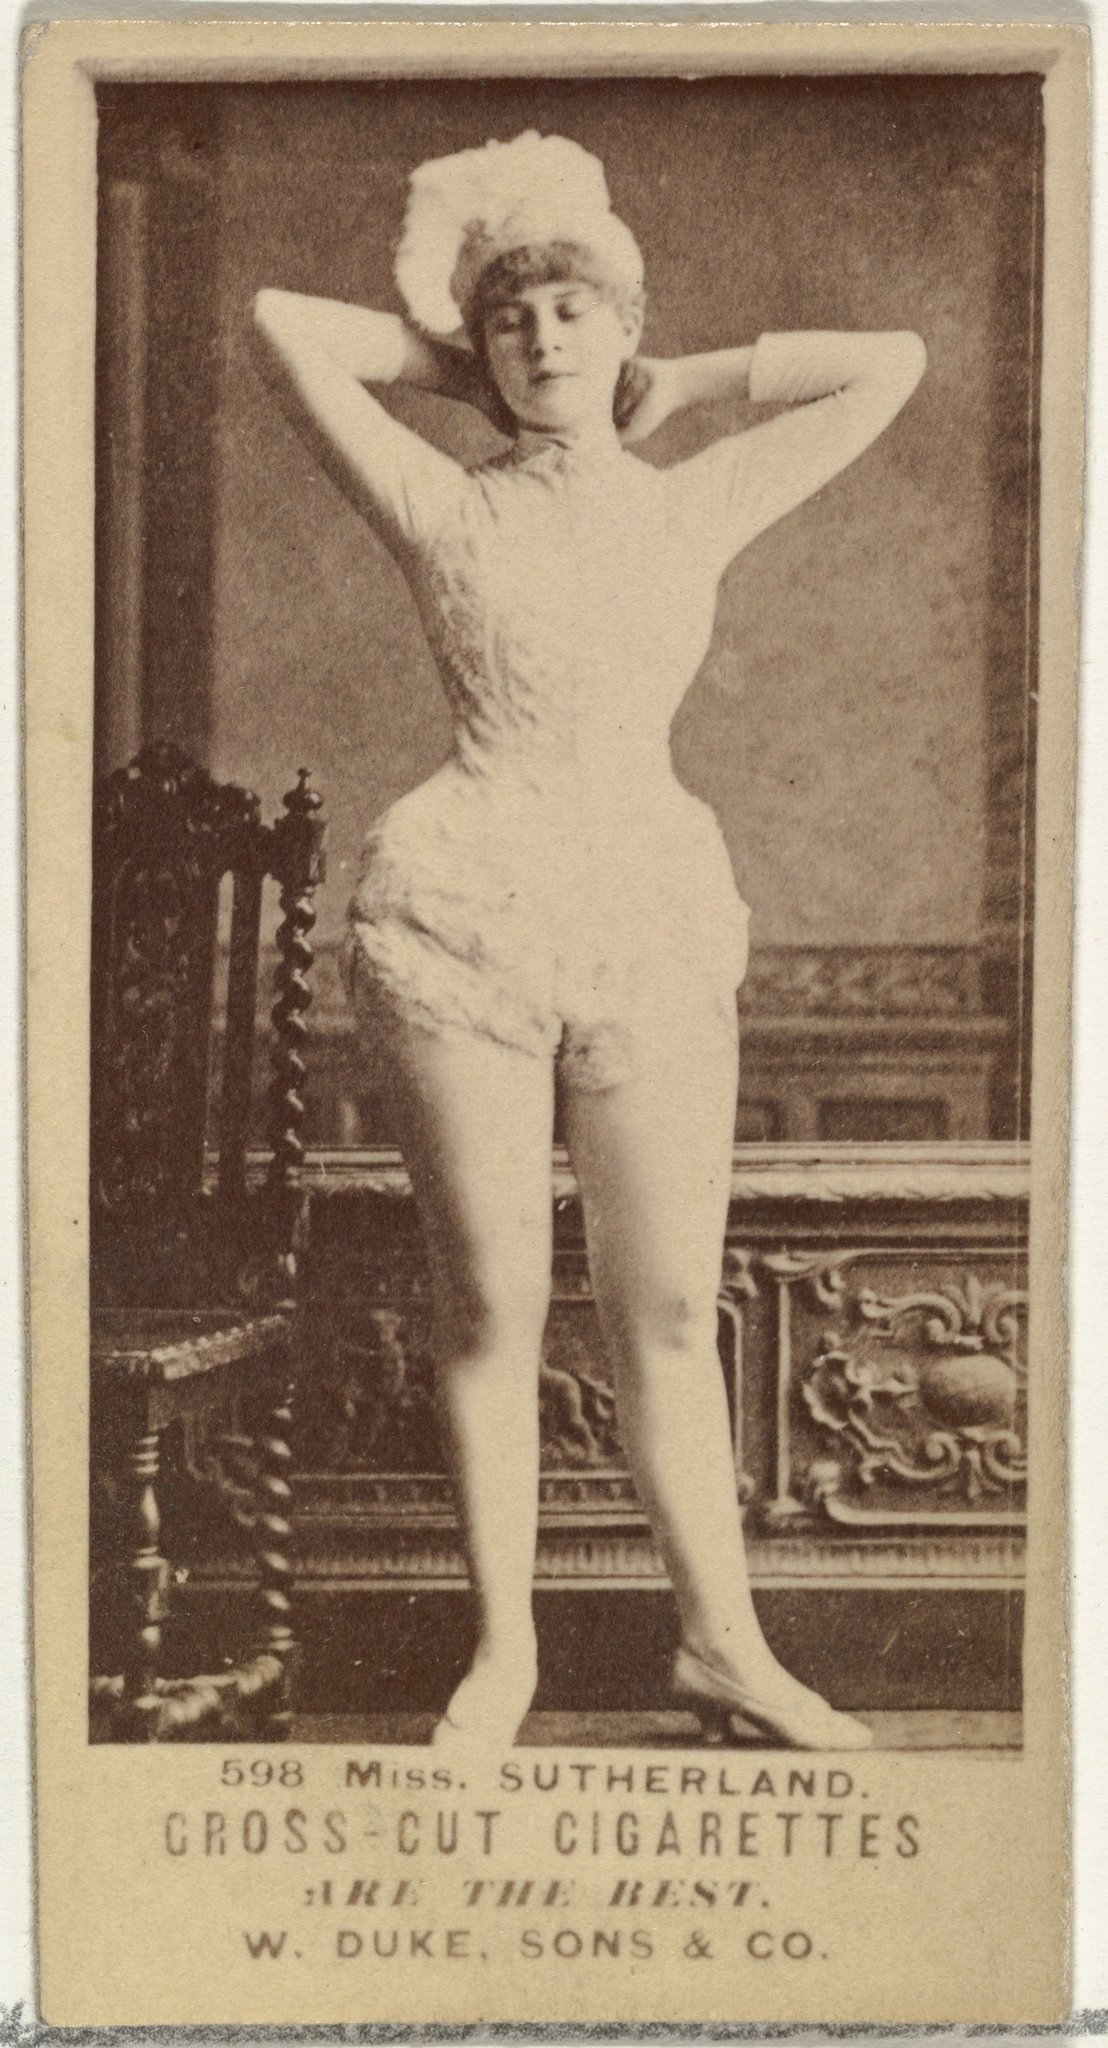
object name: photograph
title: Card Number 598, Miss Sutherland, from the Actors and Actresses series (N145-3) issued by Duke Sons & Co. to promote Cross Cut Cigarettes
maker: w. duke, sons & co.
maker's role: publisher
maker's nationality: american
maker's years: 1870-1920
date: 1880-1889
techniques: albumen silver print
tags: portraits,women,actresses